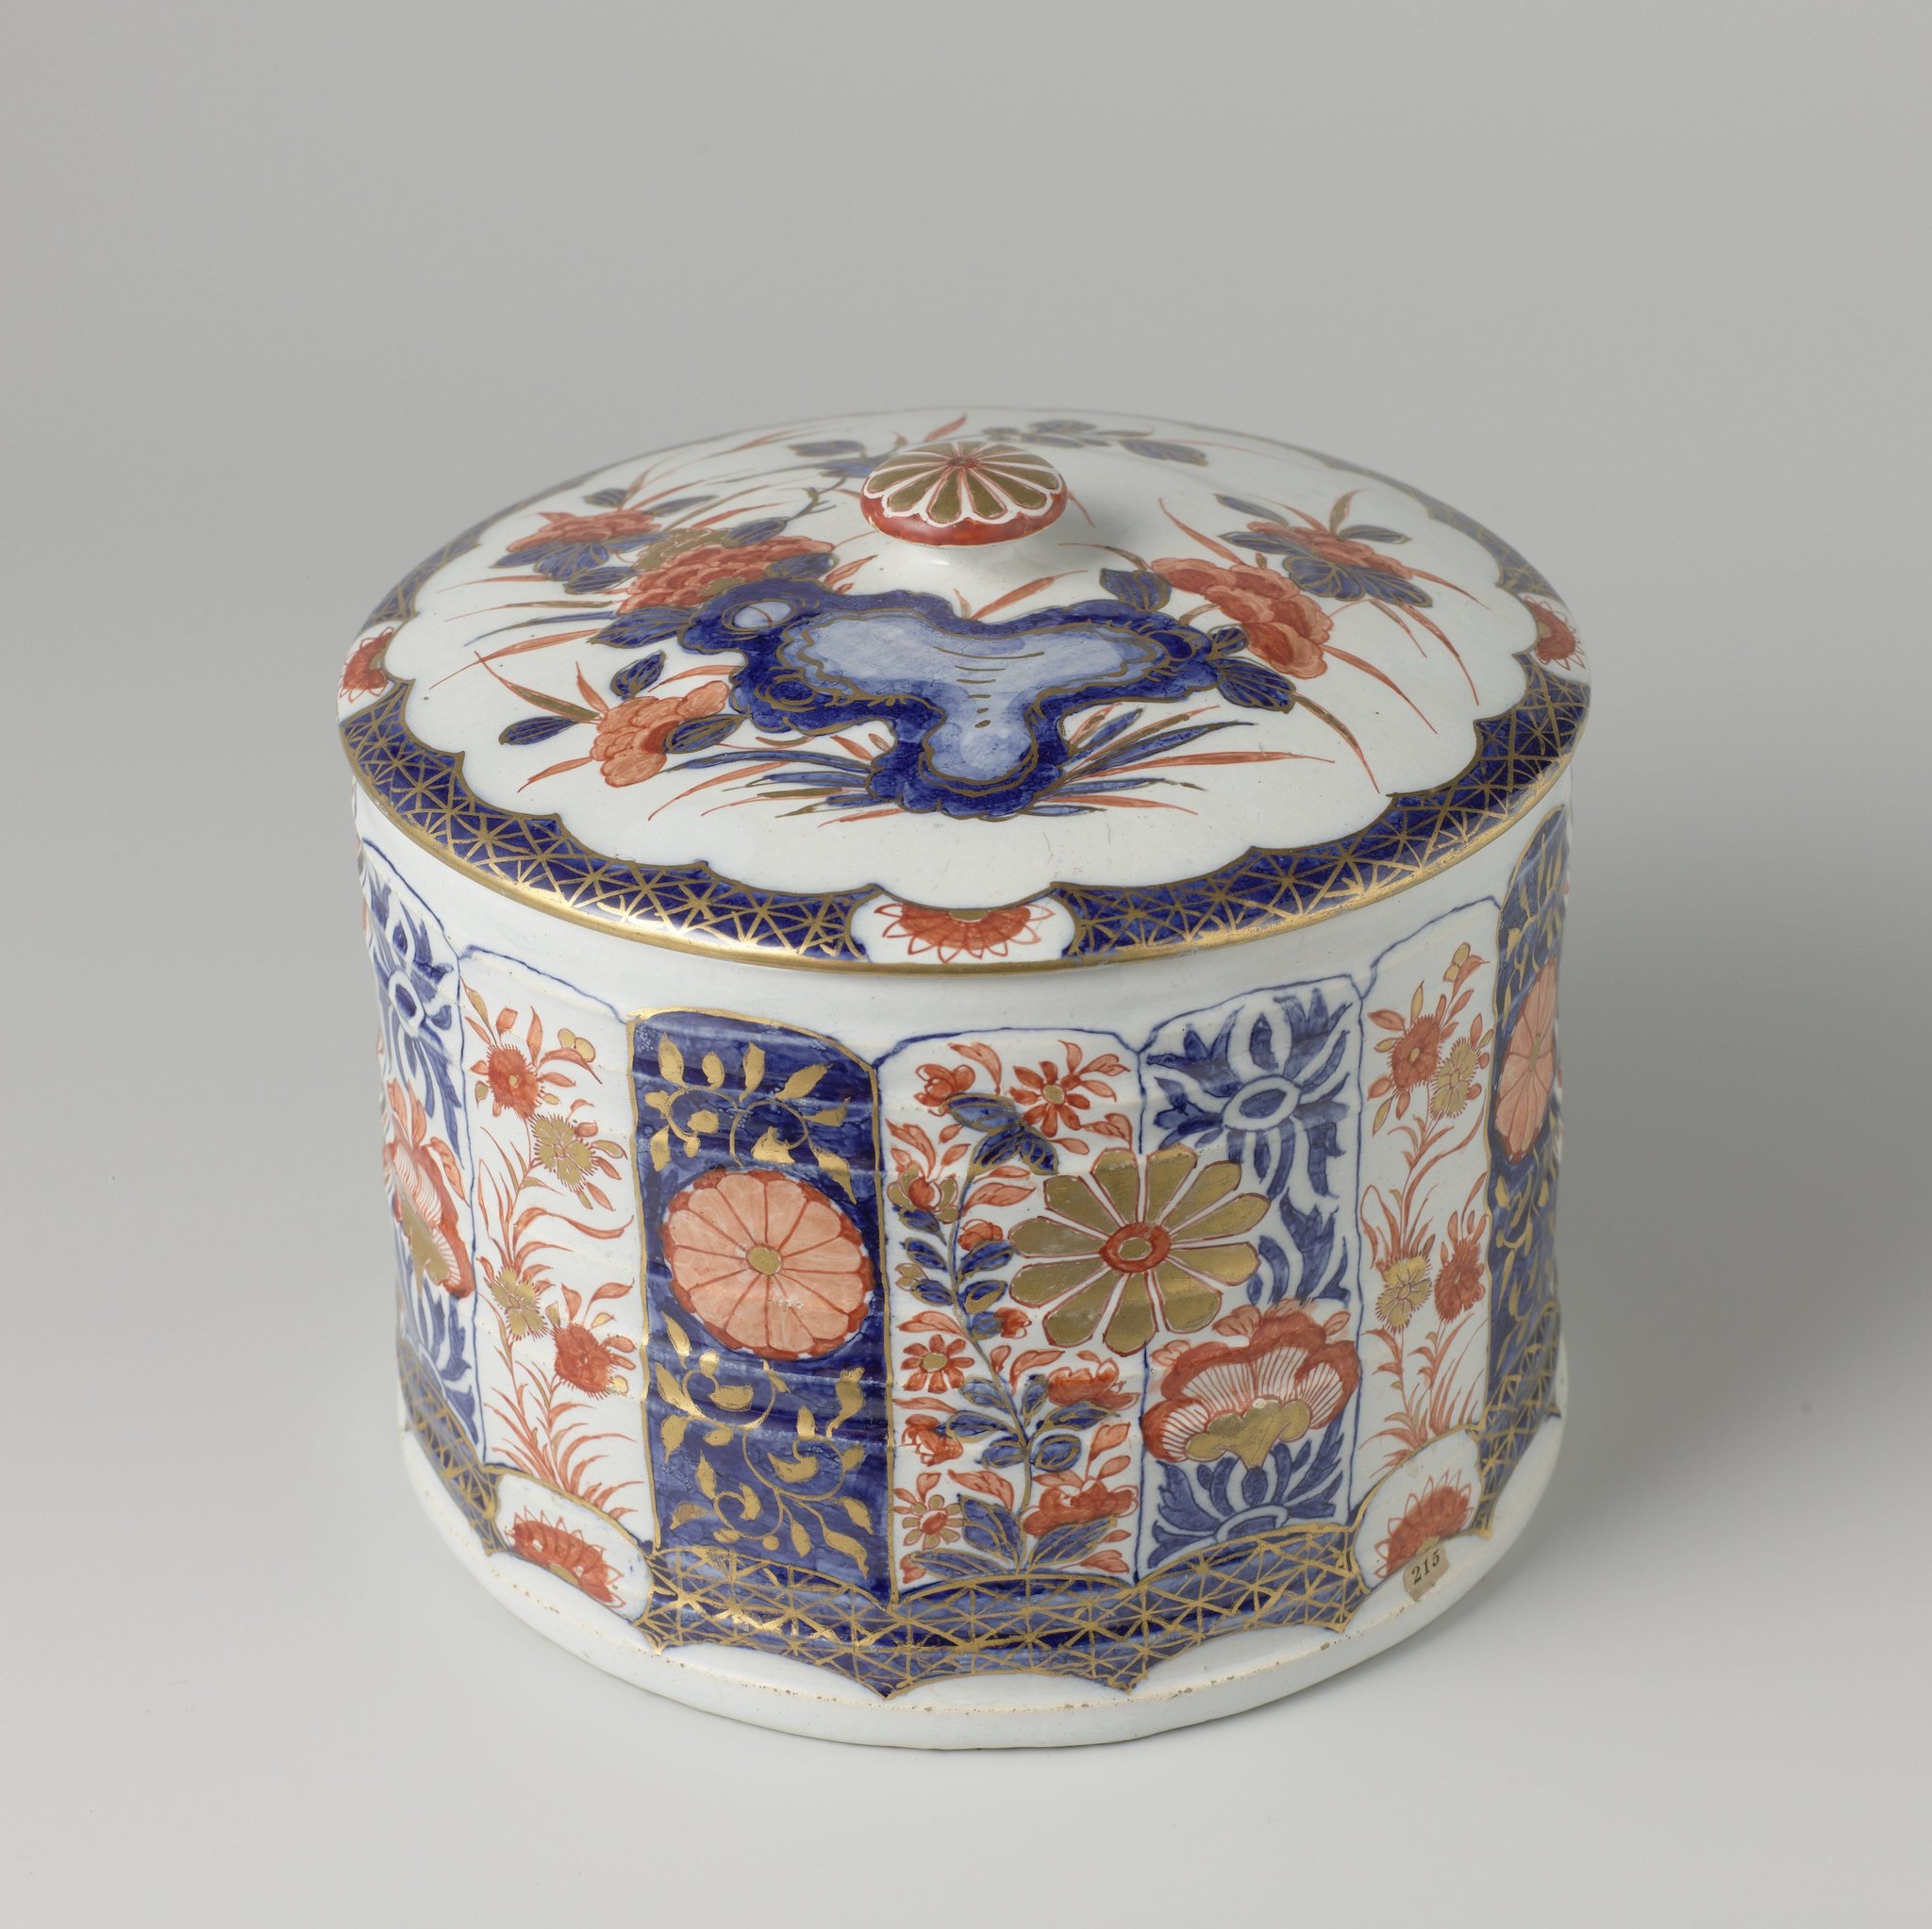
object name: box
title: Lidded box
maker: Anonymous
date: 1700-1715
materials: earthenware, glaze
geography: delft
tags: ornament derived from plant forms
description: Ronde doos van faïence. Veelkleurig beschilderd met een Imari-decoratie.